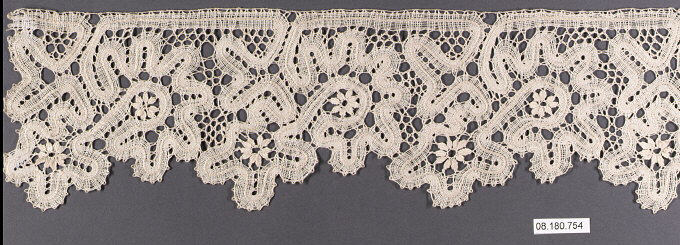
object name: fragment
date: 1801-1900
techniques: lace